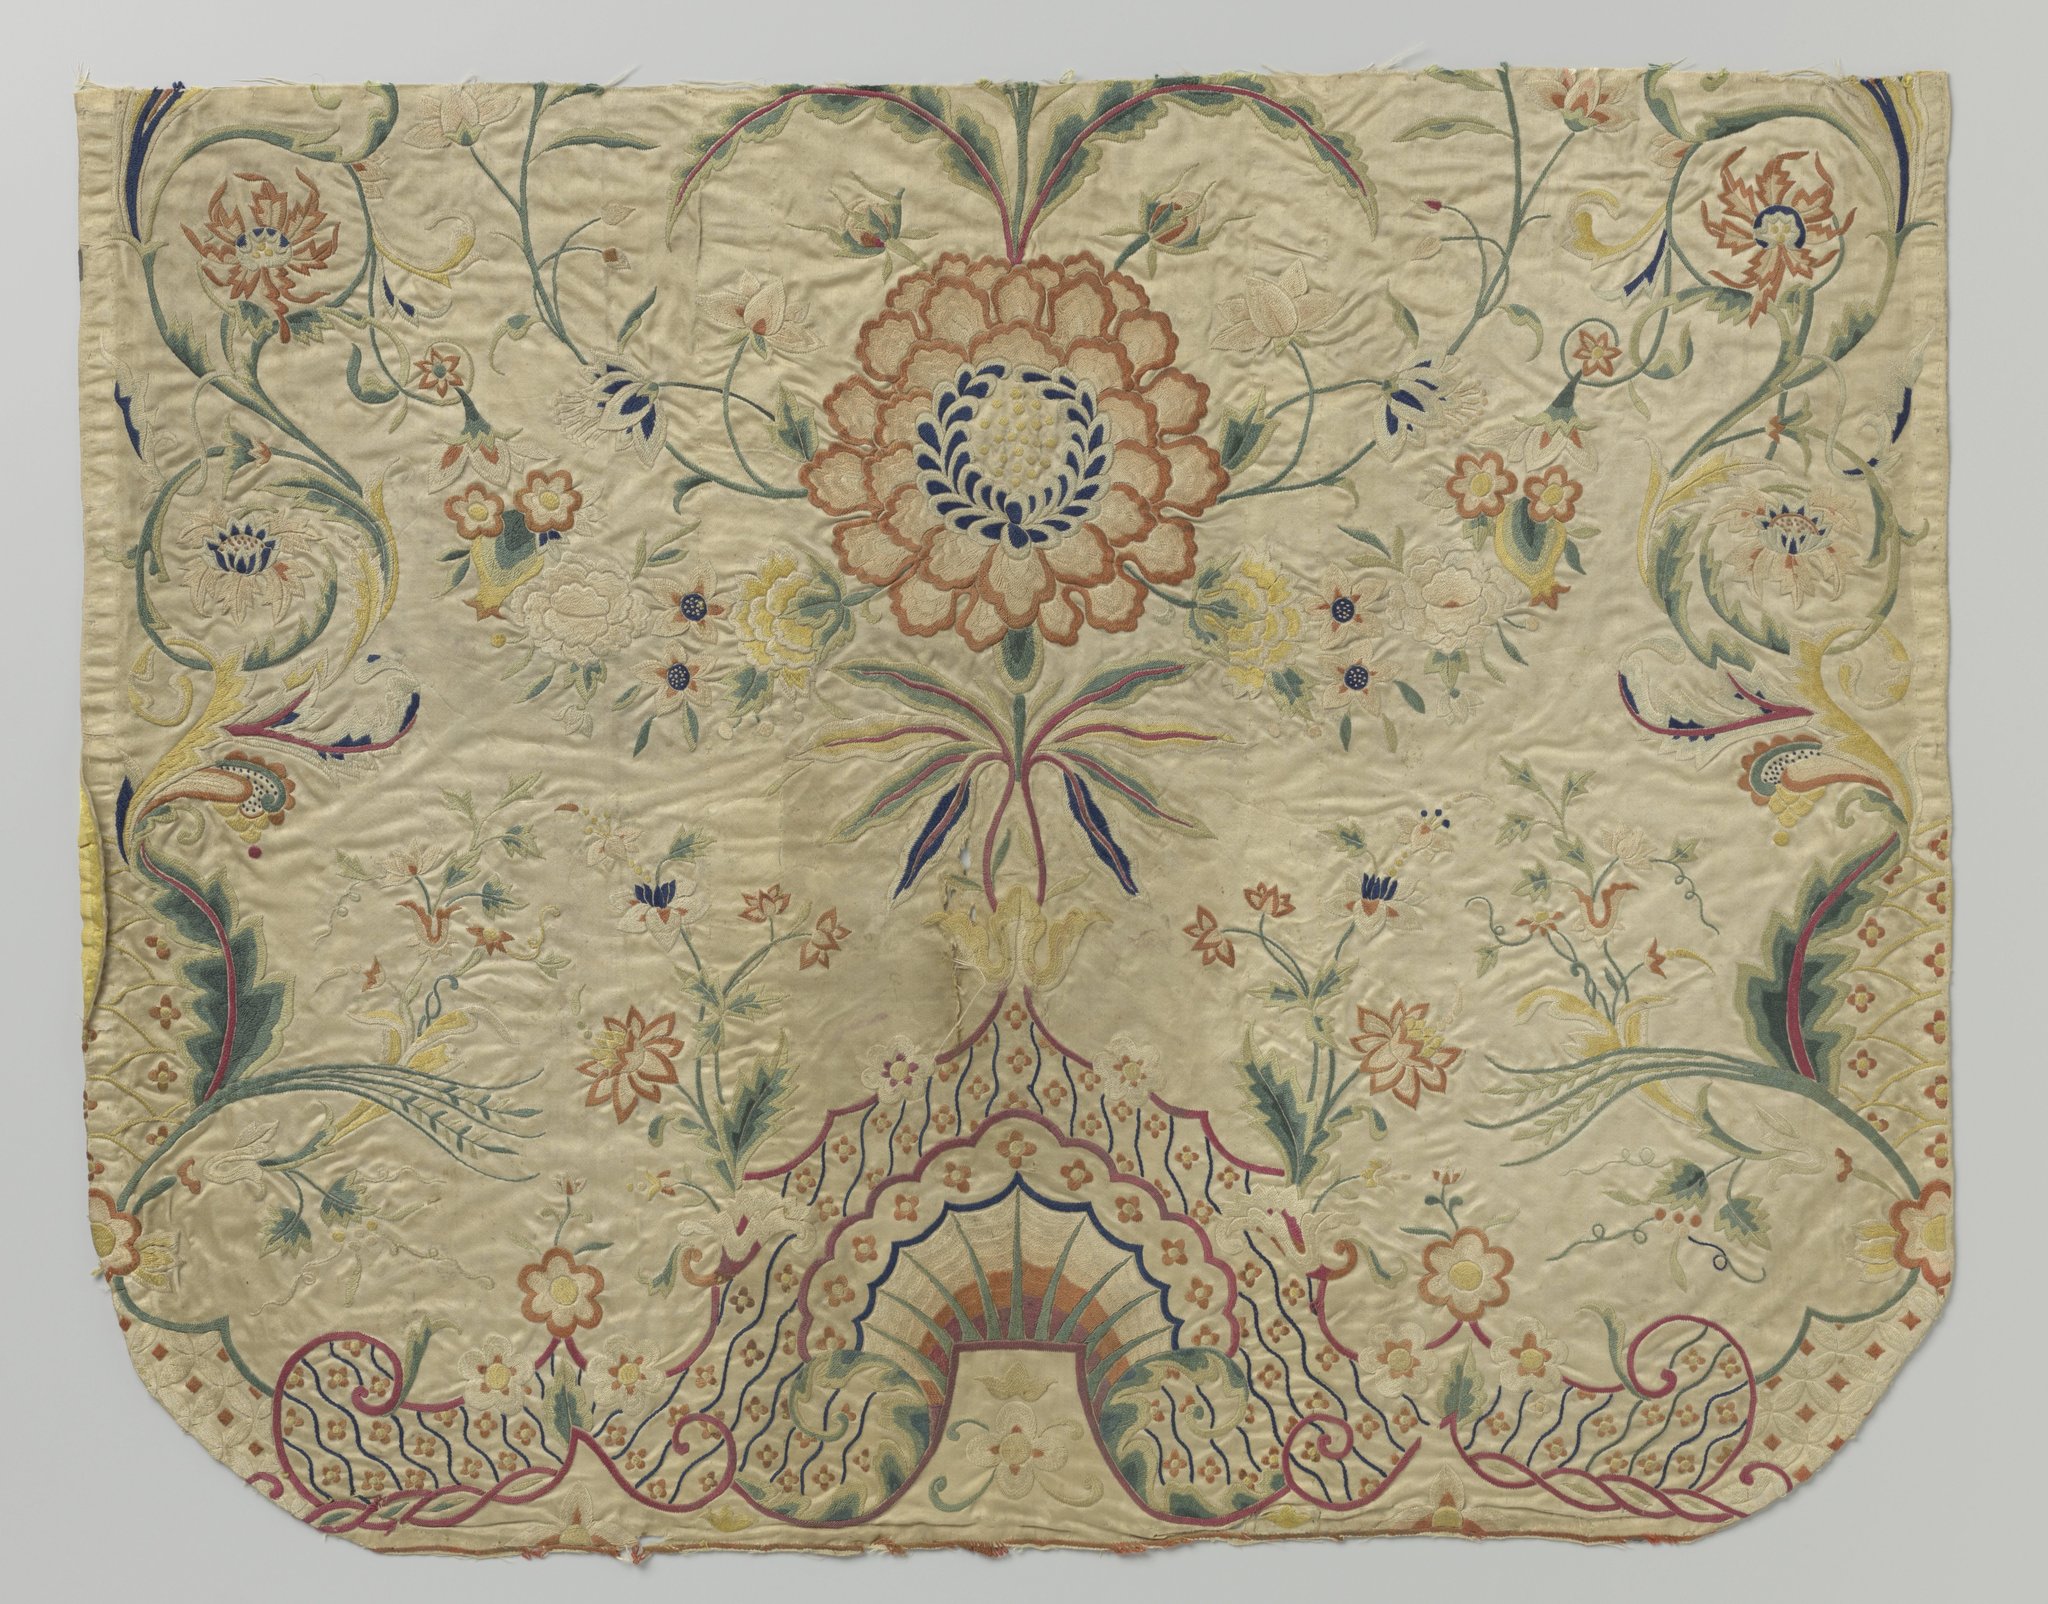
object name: embroidery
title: Fragment borduurwerk met symmetrische tekening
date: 1700-1750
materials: textile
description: Fragment borduurwerk. Op roomkleurig satijn is een symmetrische tekening geborduurd met ingrijpsteek. Onder een palmetmotief omringd door festons en rozetbloemen en bekroond door een kelk, waaruit zich twee takken met spitse bladeren ontwikkelen, die een grote lichtgele bloem met rode omrandingen en blauw en wit middenstuk dragen. Aan weerszijden van deze grote bloem takken met diverse lichtkleurige bloemen, terwijl aan de beide zijden forse ranken zijn geborduurd.